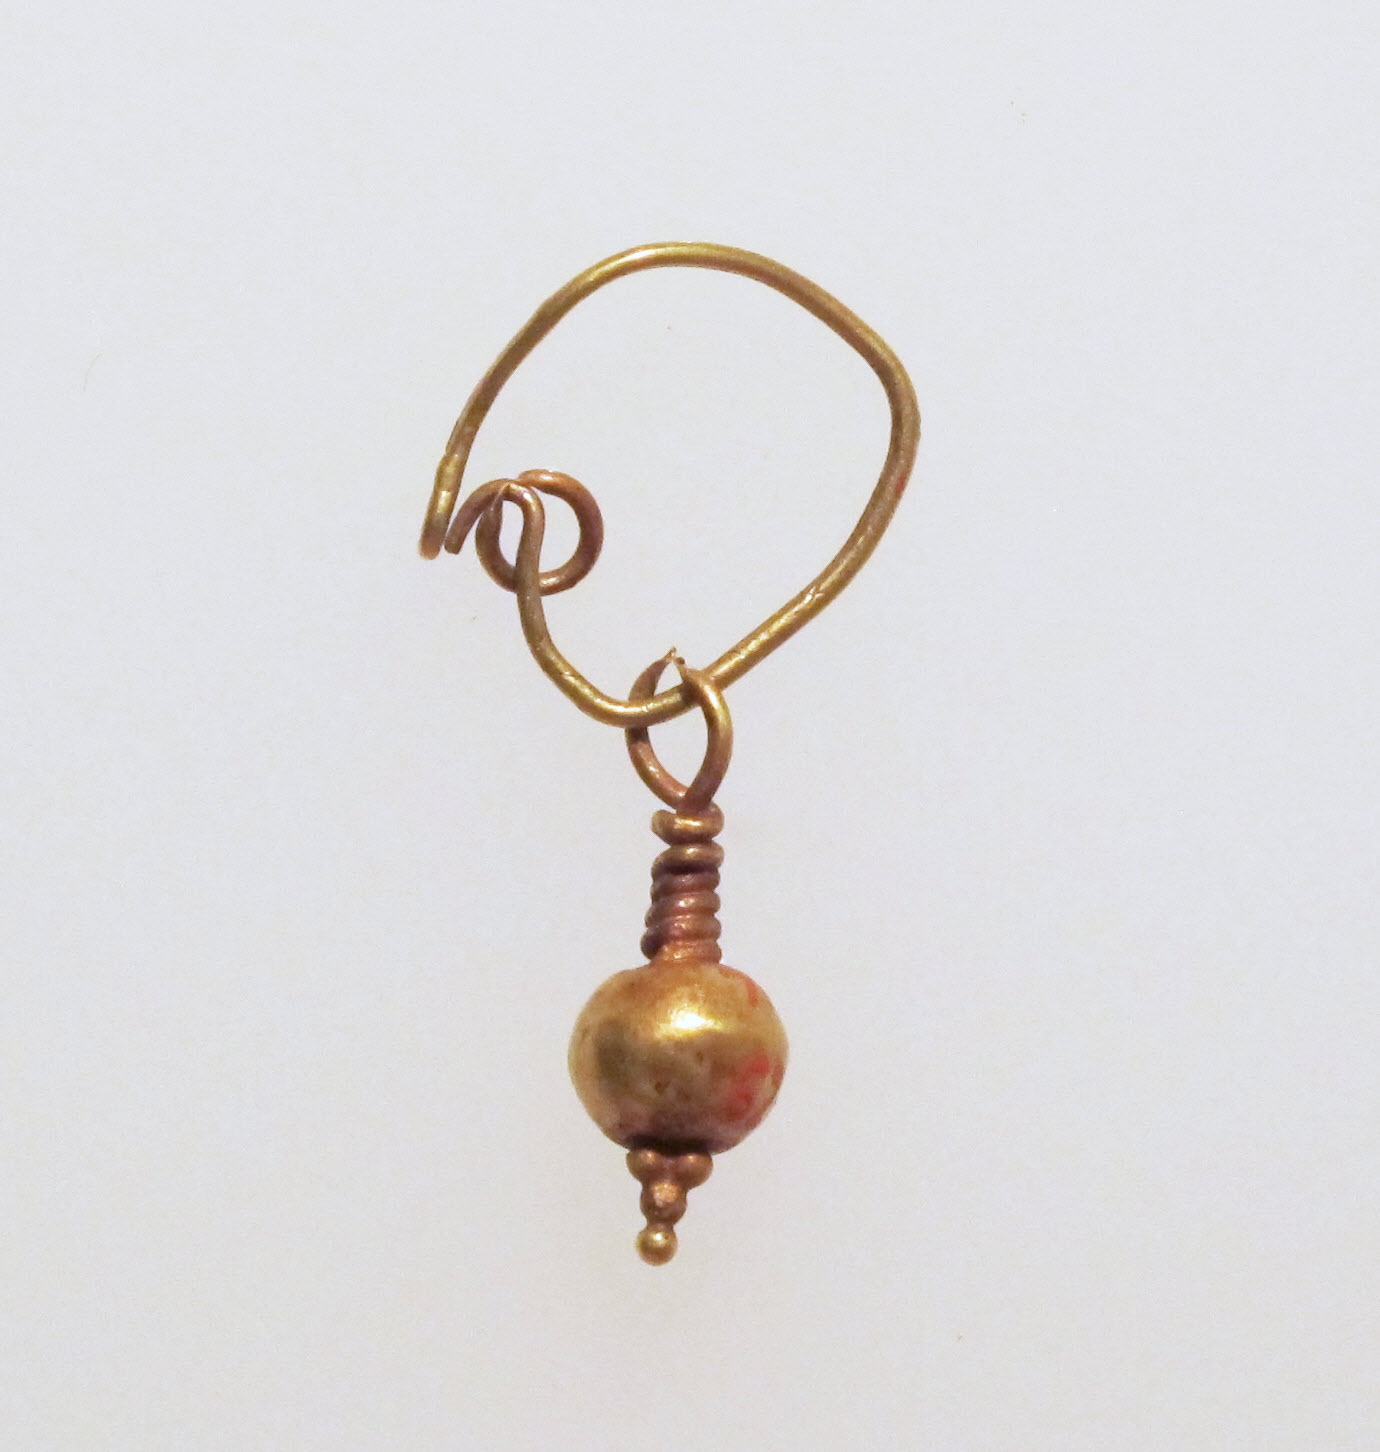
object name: earring with pendant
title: Gold earring with pendant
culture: roman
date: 101-200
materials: gold